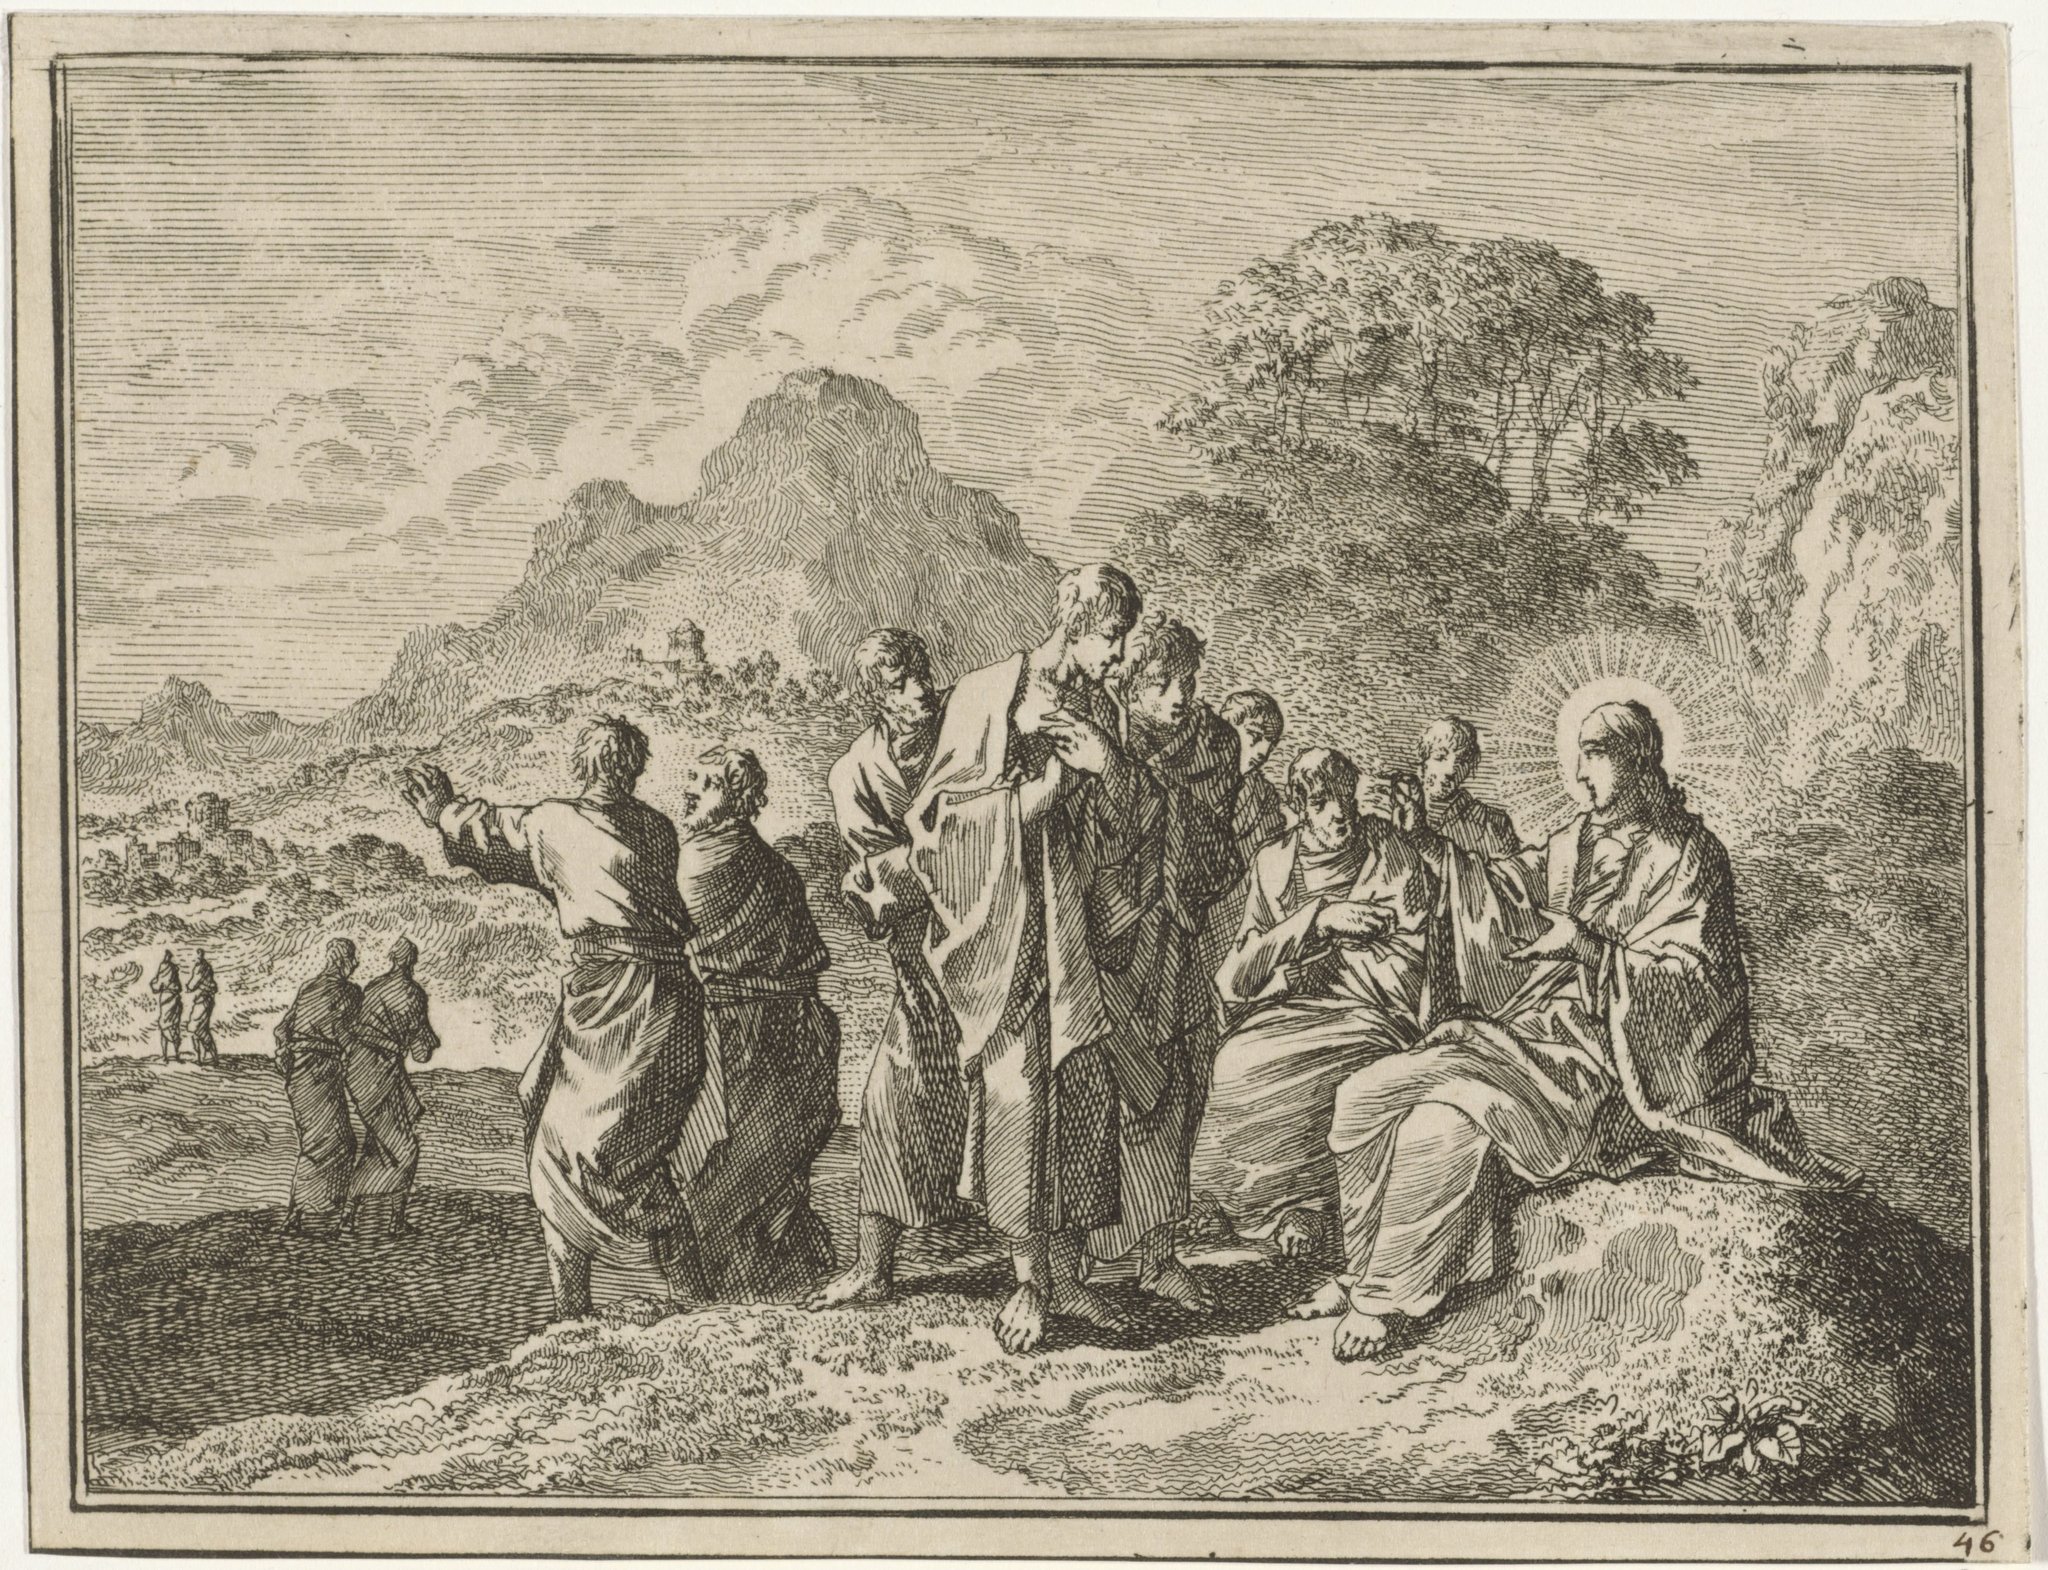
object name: print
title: Christus zendt de twaalf apostelen uit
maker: jan luyken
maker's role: draughtsman, print maker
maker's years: 1649-1712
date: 1712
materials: paper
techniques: etching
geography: amsterdam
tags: christ sends apostles out in pairs (matthew 10:1-16; mark 6:7-11; luke 9:1-5)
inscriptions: number: ‘46’, collector's mark: Lugt 2228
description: Proefdruk van illustratie uit: Luyken, Jan. De schriftuurlyke geschiedenissen en gelykenissen van het Oude en Nieuwe Verbond, 2 delen. Amsterdam: Wed. Pieter Arentsz II en Cornelis van der Sys, 1712, dl. II.